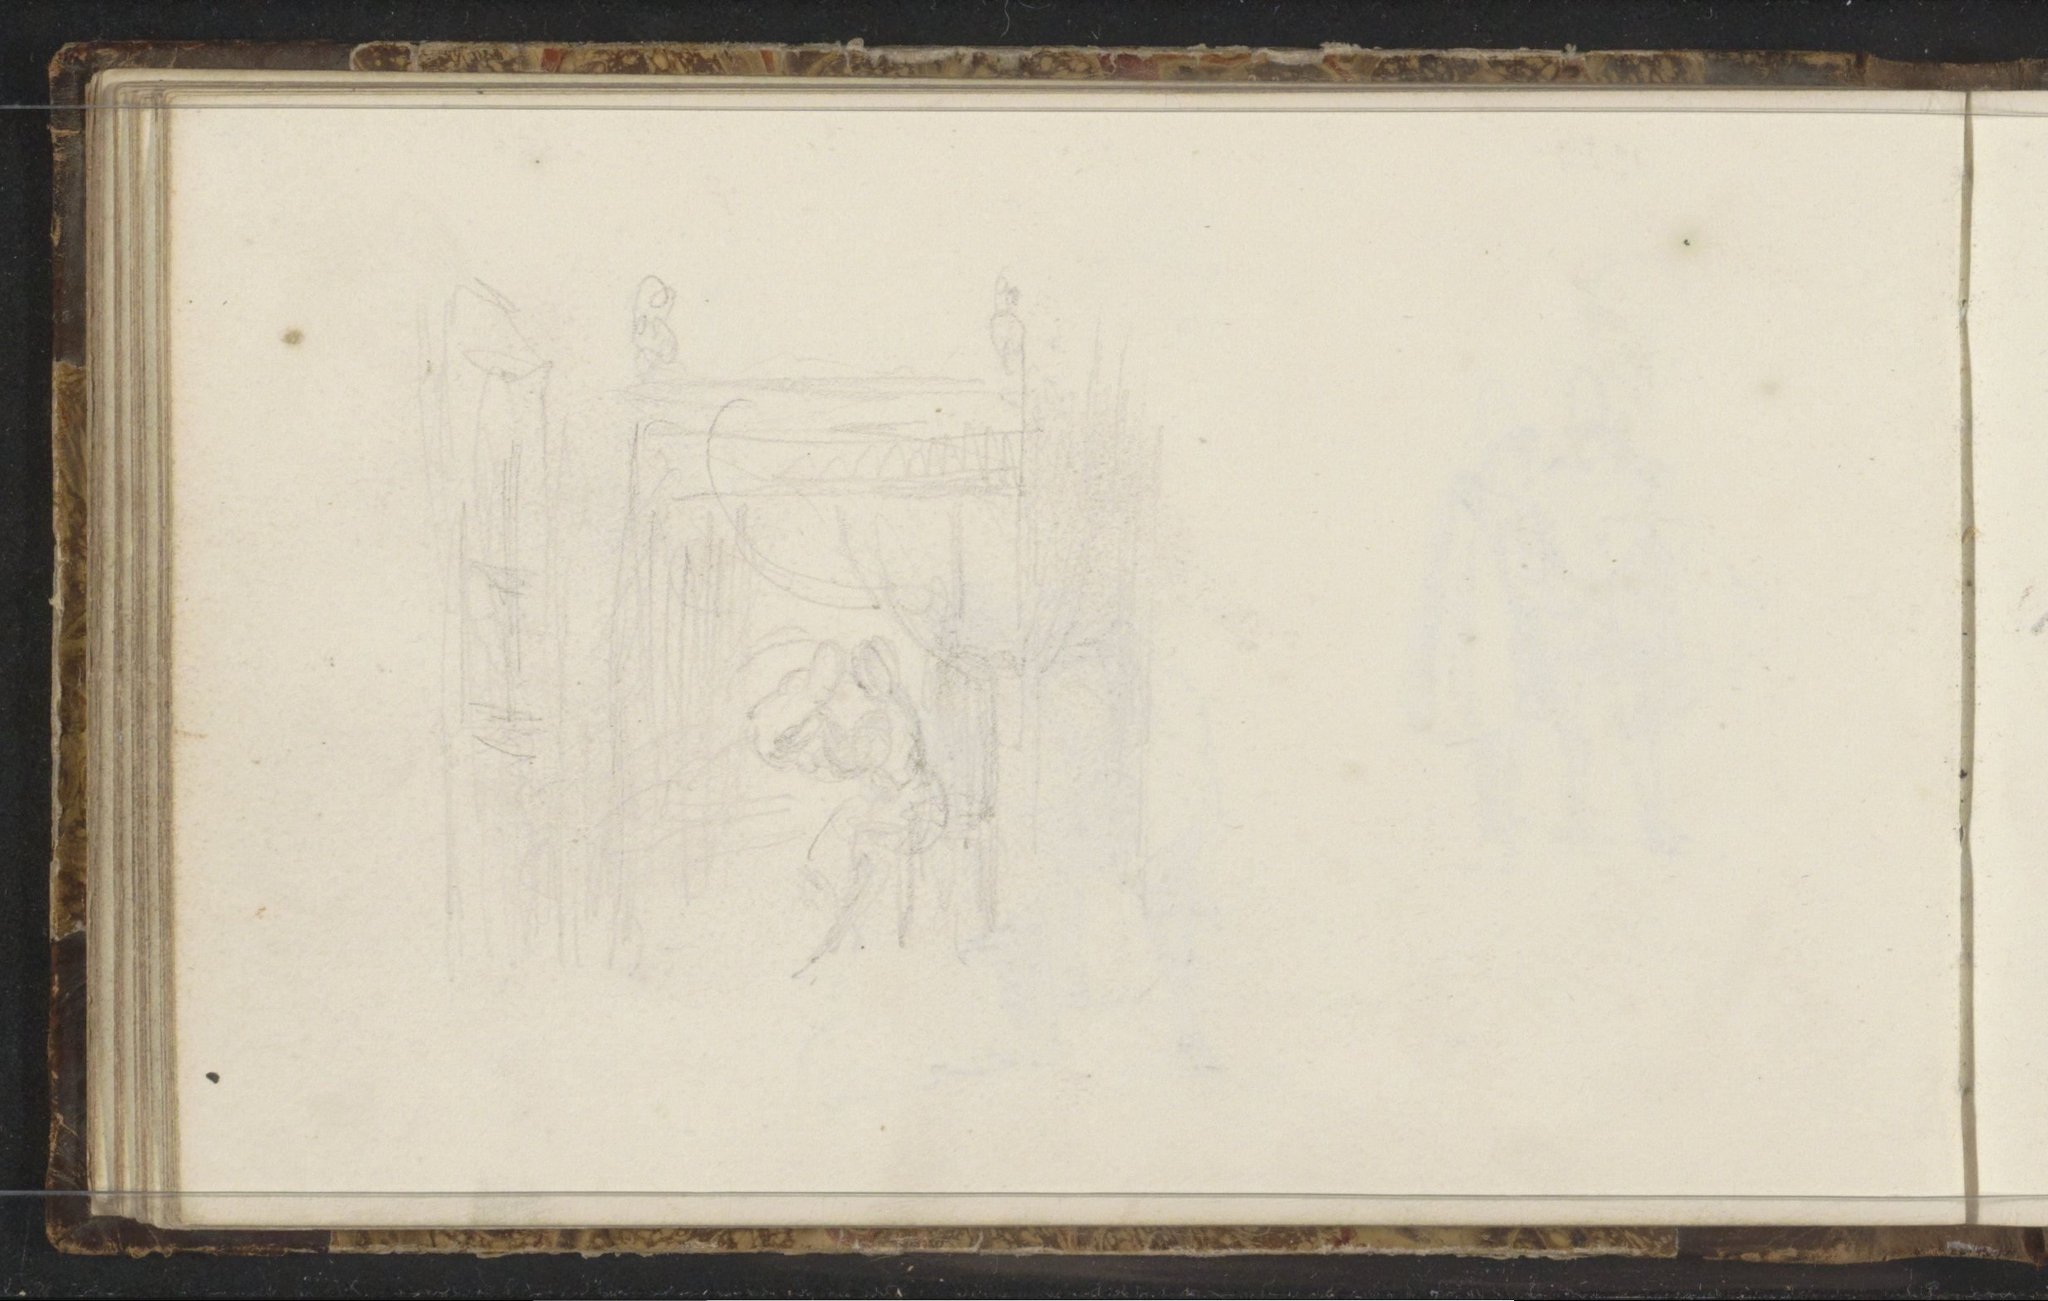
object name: sketchbook leaf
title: Paar gezeten op een hemelbed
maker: willem hendrik schmidt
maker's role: draughtsman, painter, print maker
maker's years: 1809-1849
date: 1819-1849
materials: paper, pencil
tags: bed, couple of lovers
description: Blad 29 verso uit een schetsboek met 60 bladen.